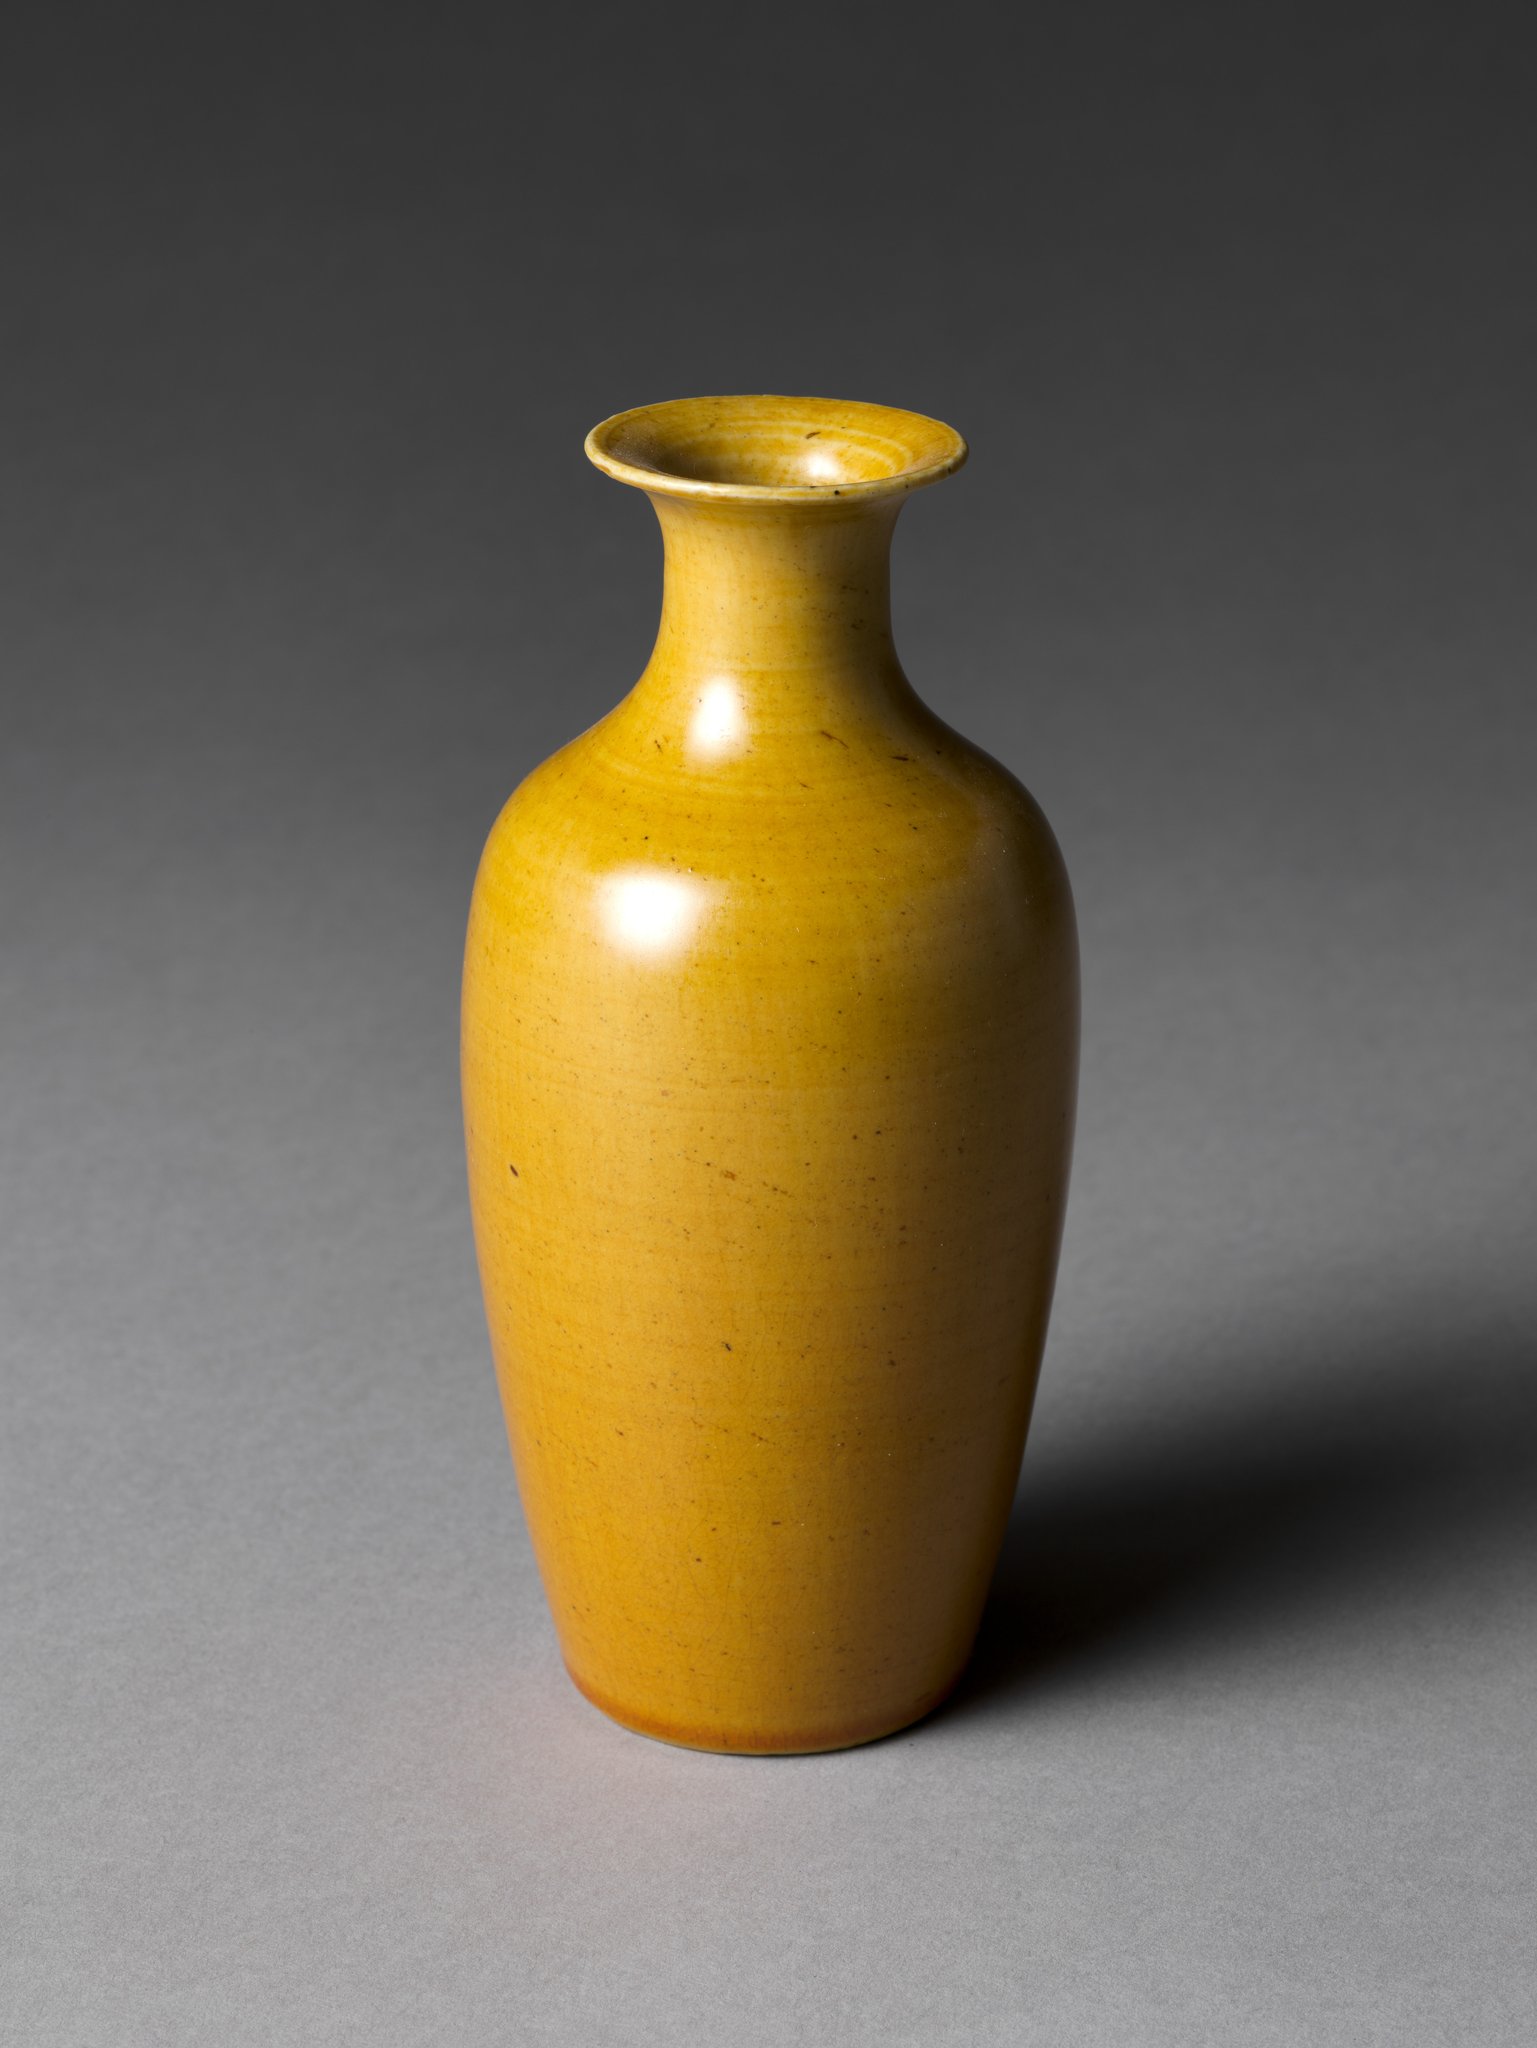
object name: vase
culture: chinese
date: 1767-1900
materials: glaze, porcelain